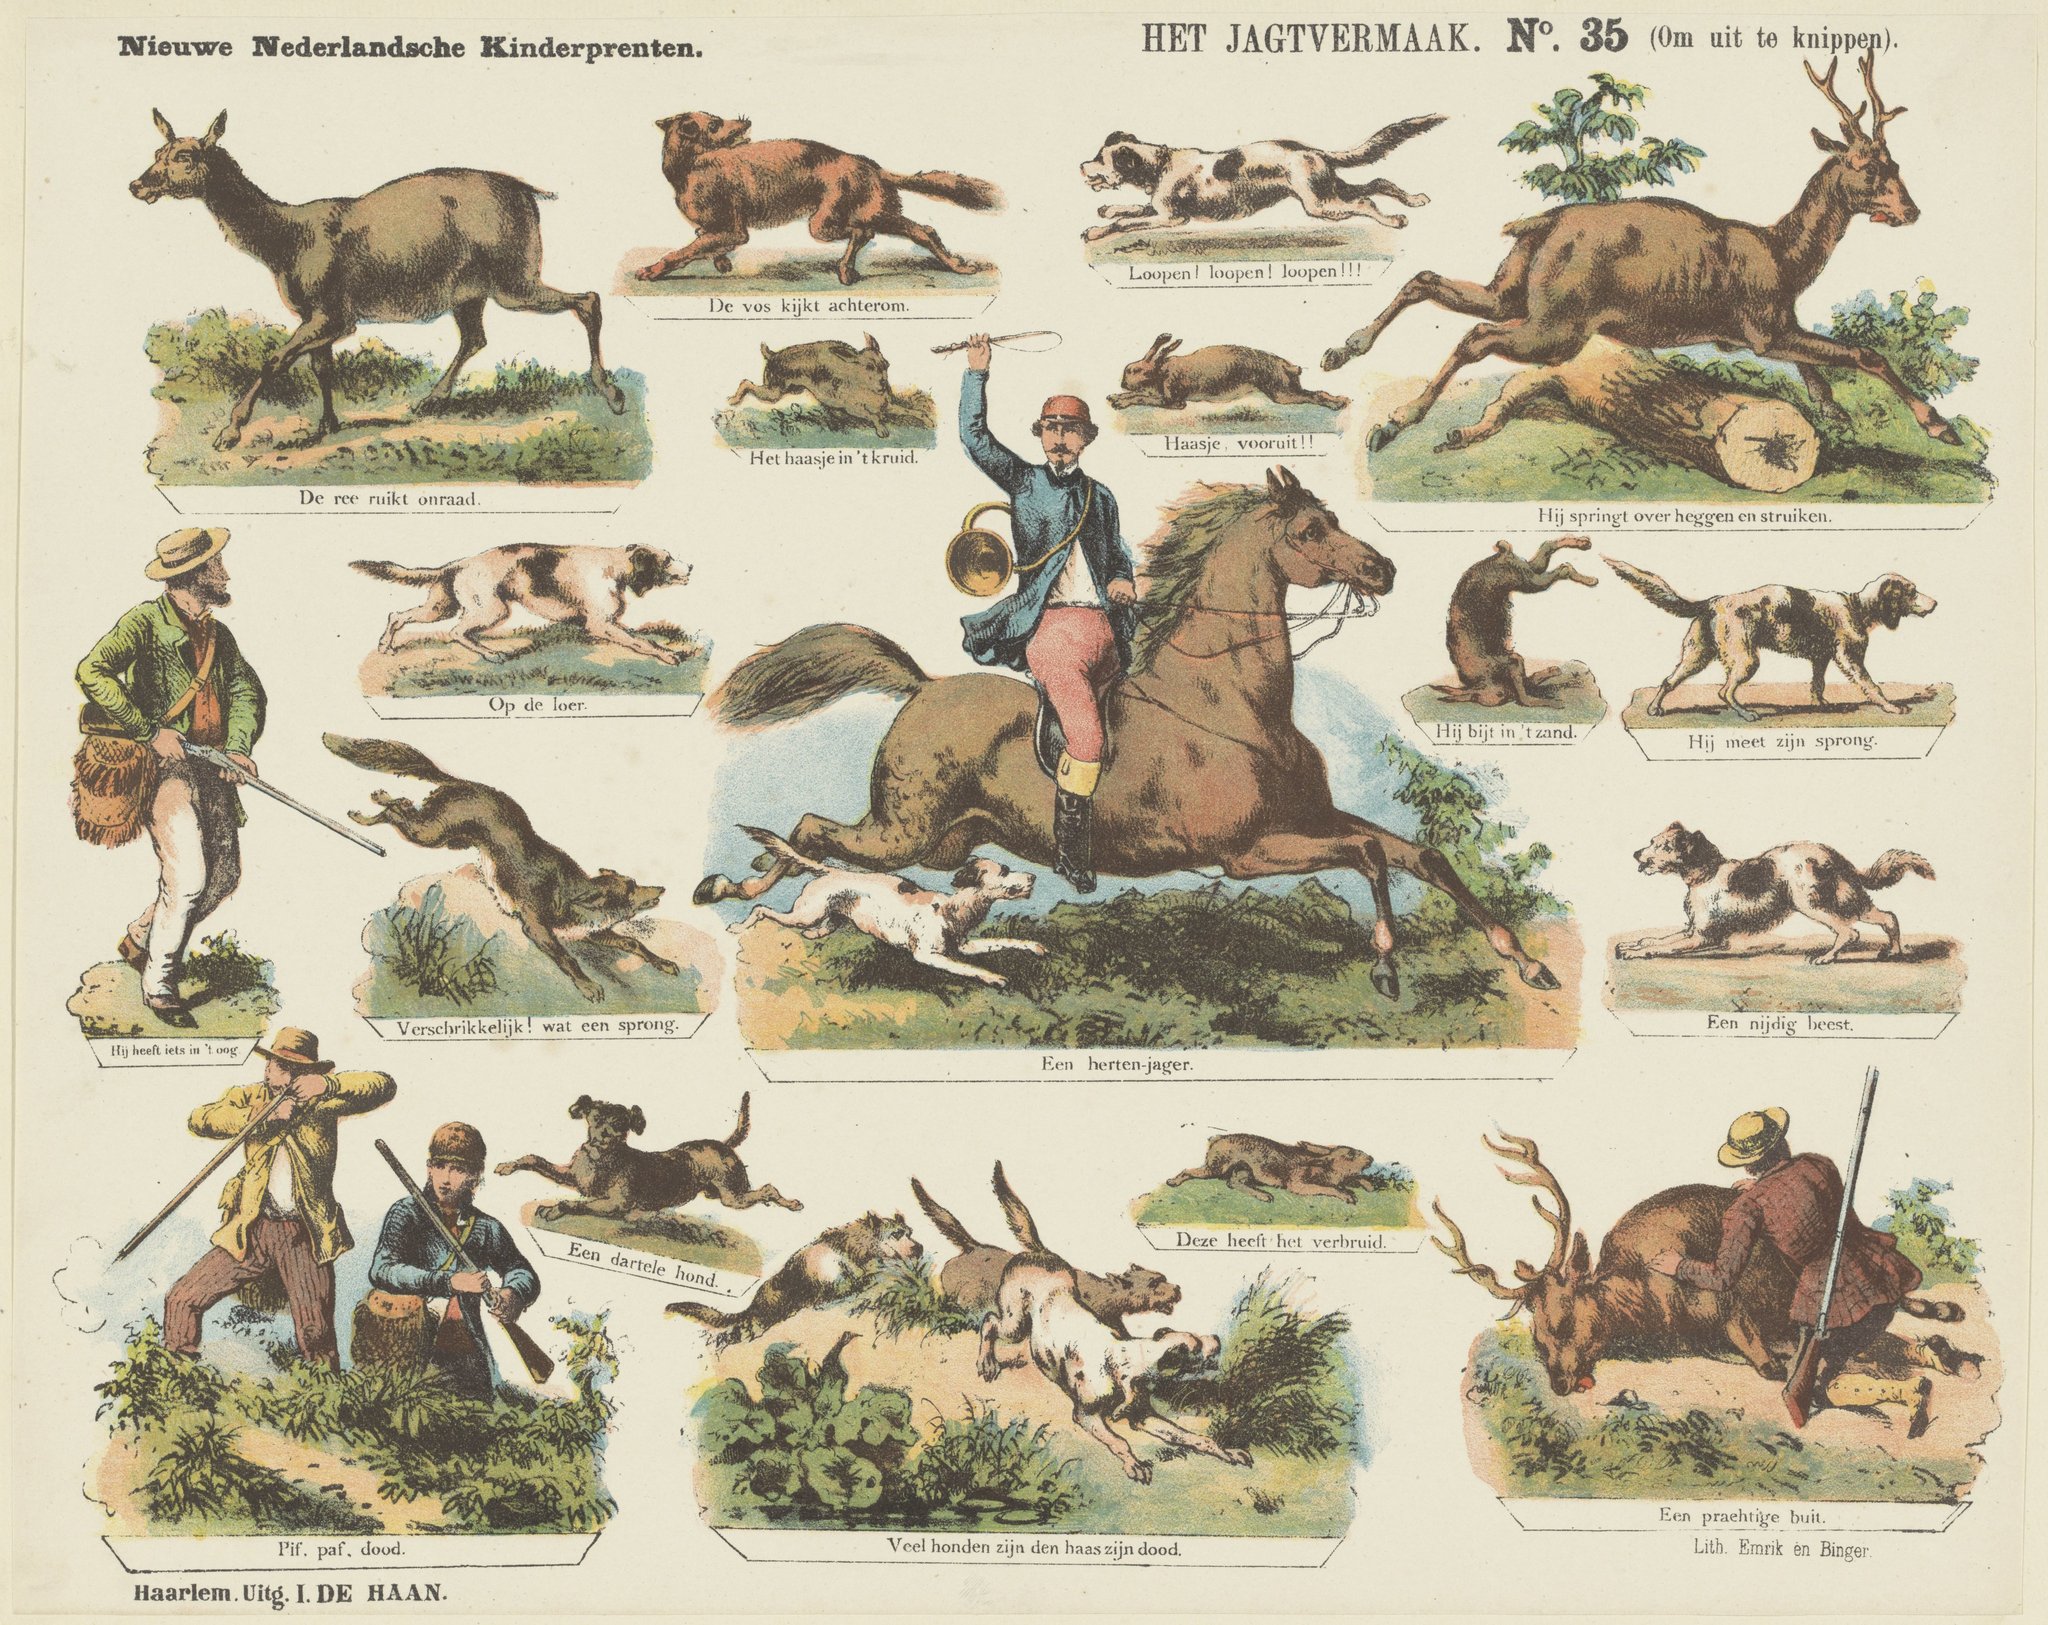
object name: popular print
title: Het jagtvermaak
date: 1875-1903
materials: paper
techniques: lithograph, letterpress printing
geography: haarlem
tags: hunting dogs, hunter, hunters hunting (n.b.: in 1988-1990 this notation denoted the concept of 43c11421 'hunters resting during the hunt'), hunt ~ mammals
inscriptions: collector's mark: Lugt 2760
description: Blad met 18 voorstellingen van jagers, jachthonden en wild om uit te knippen. Onder elke afbeelding een onderschrift. Genummerd rechtsboven: No. 35.